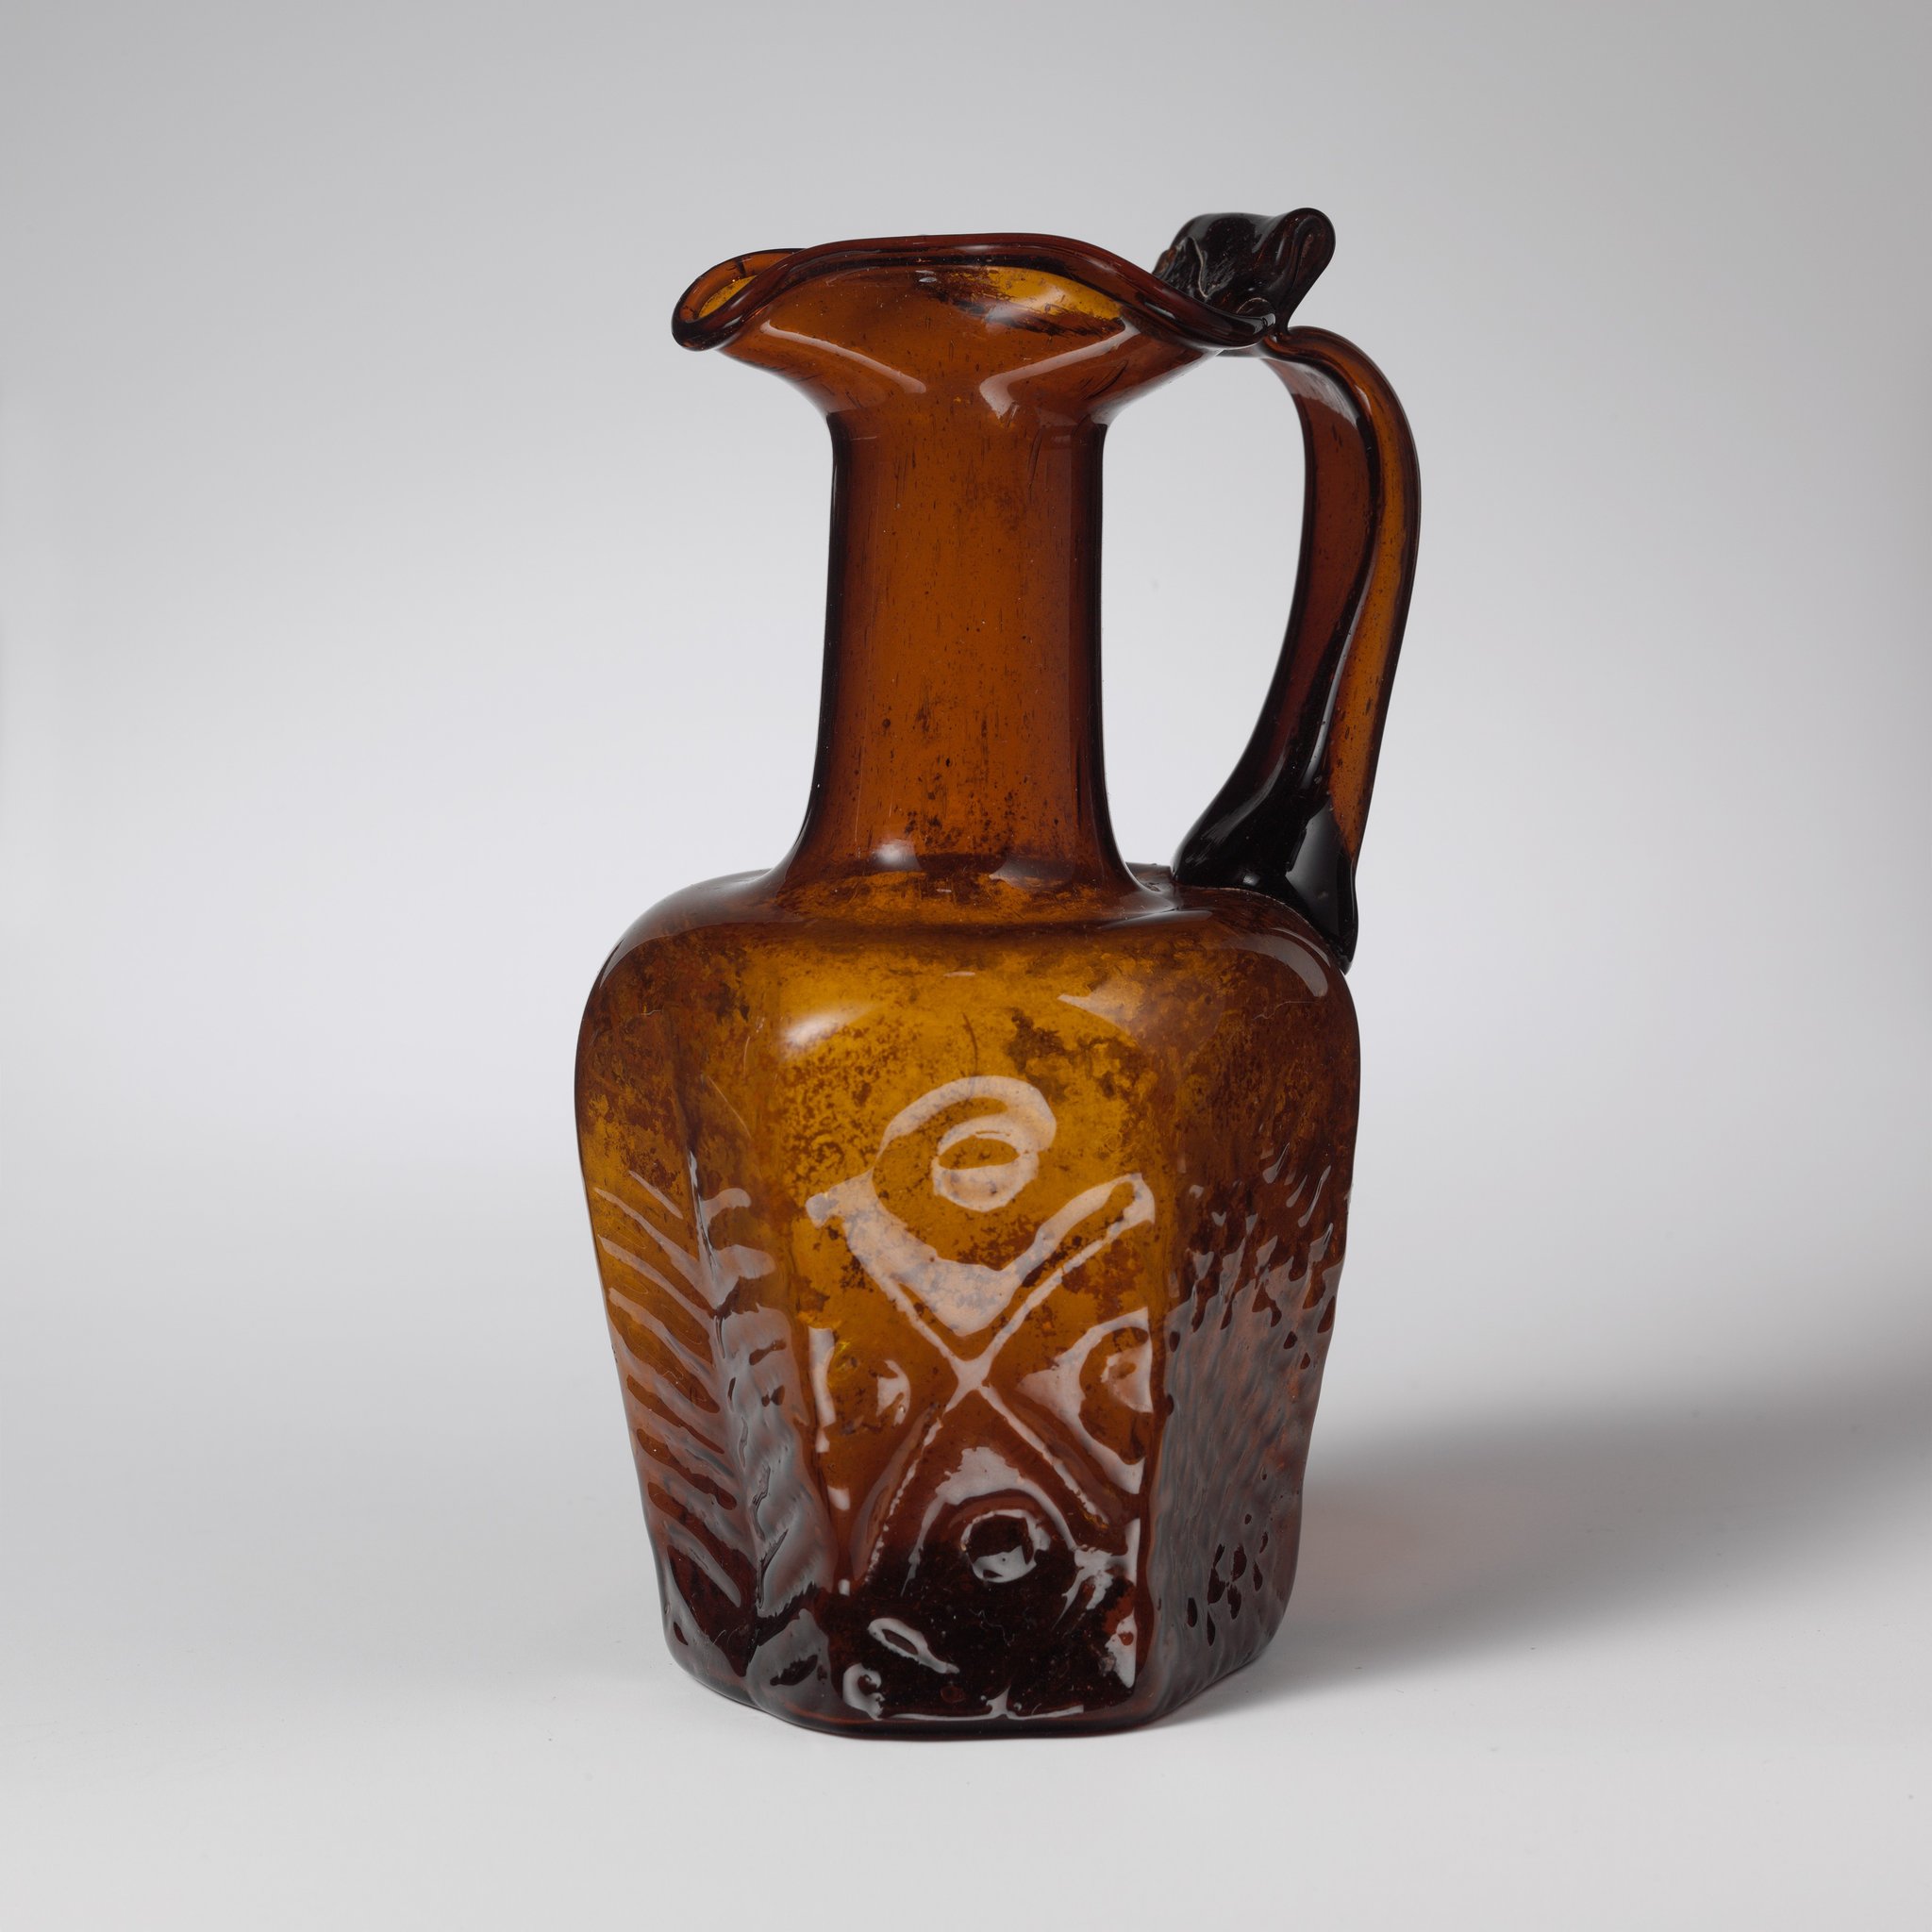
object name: jug, hexagonal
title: Glass hexagonal jug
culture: roman, palestinian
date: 501-633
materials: glass